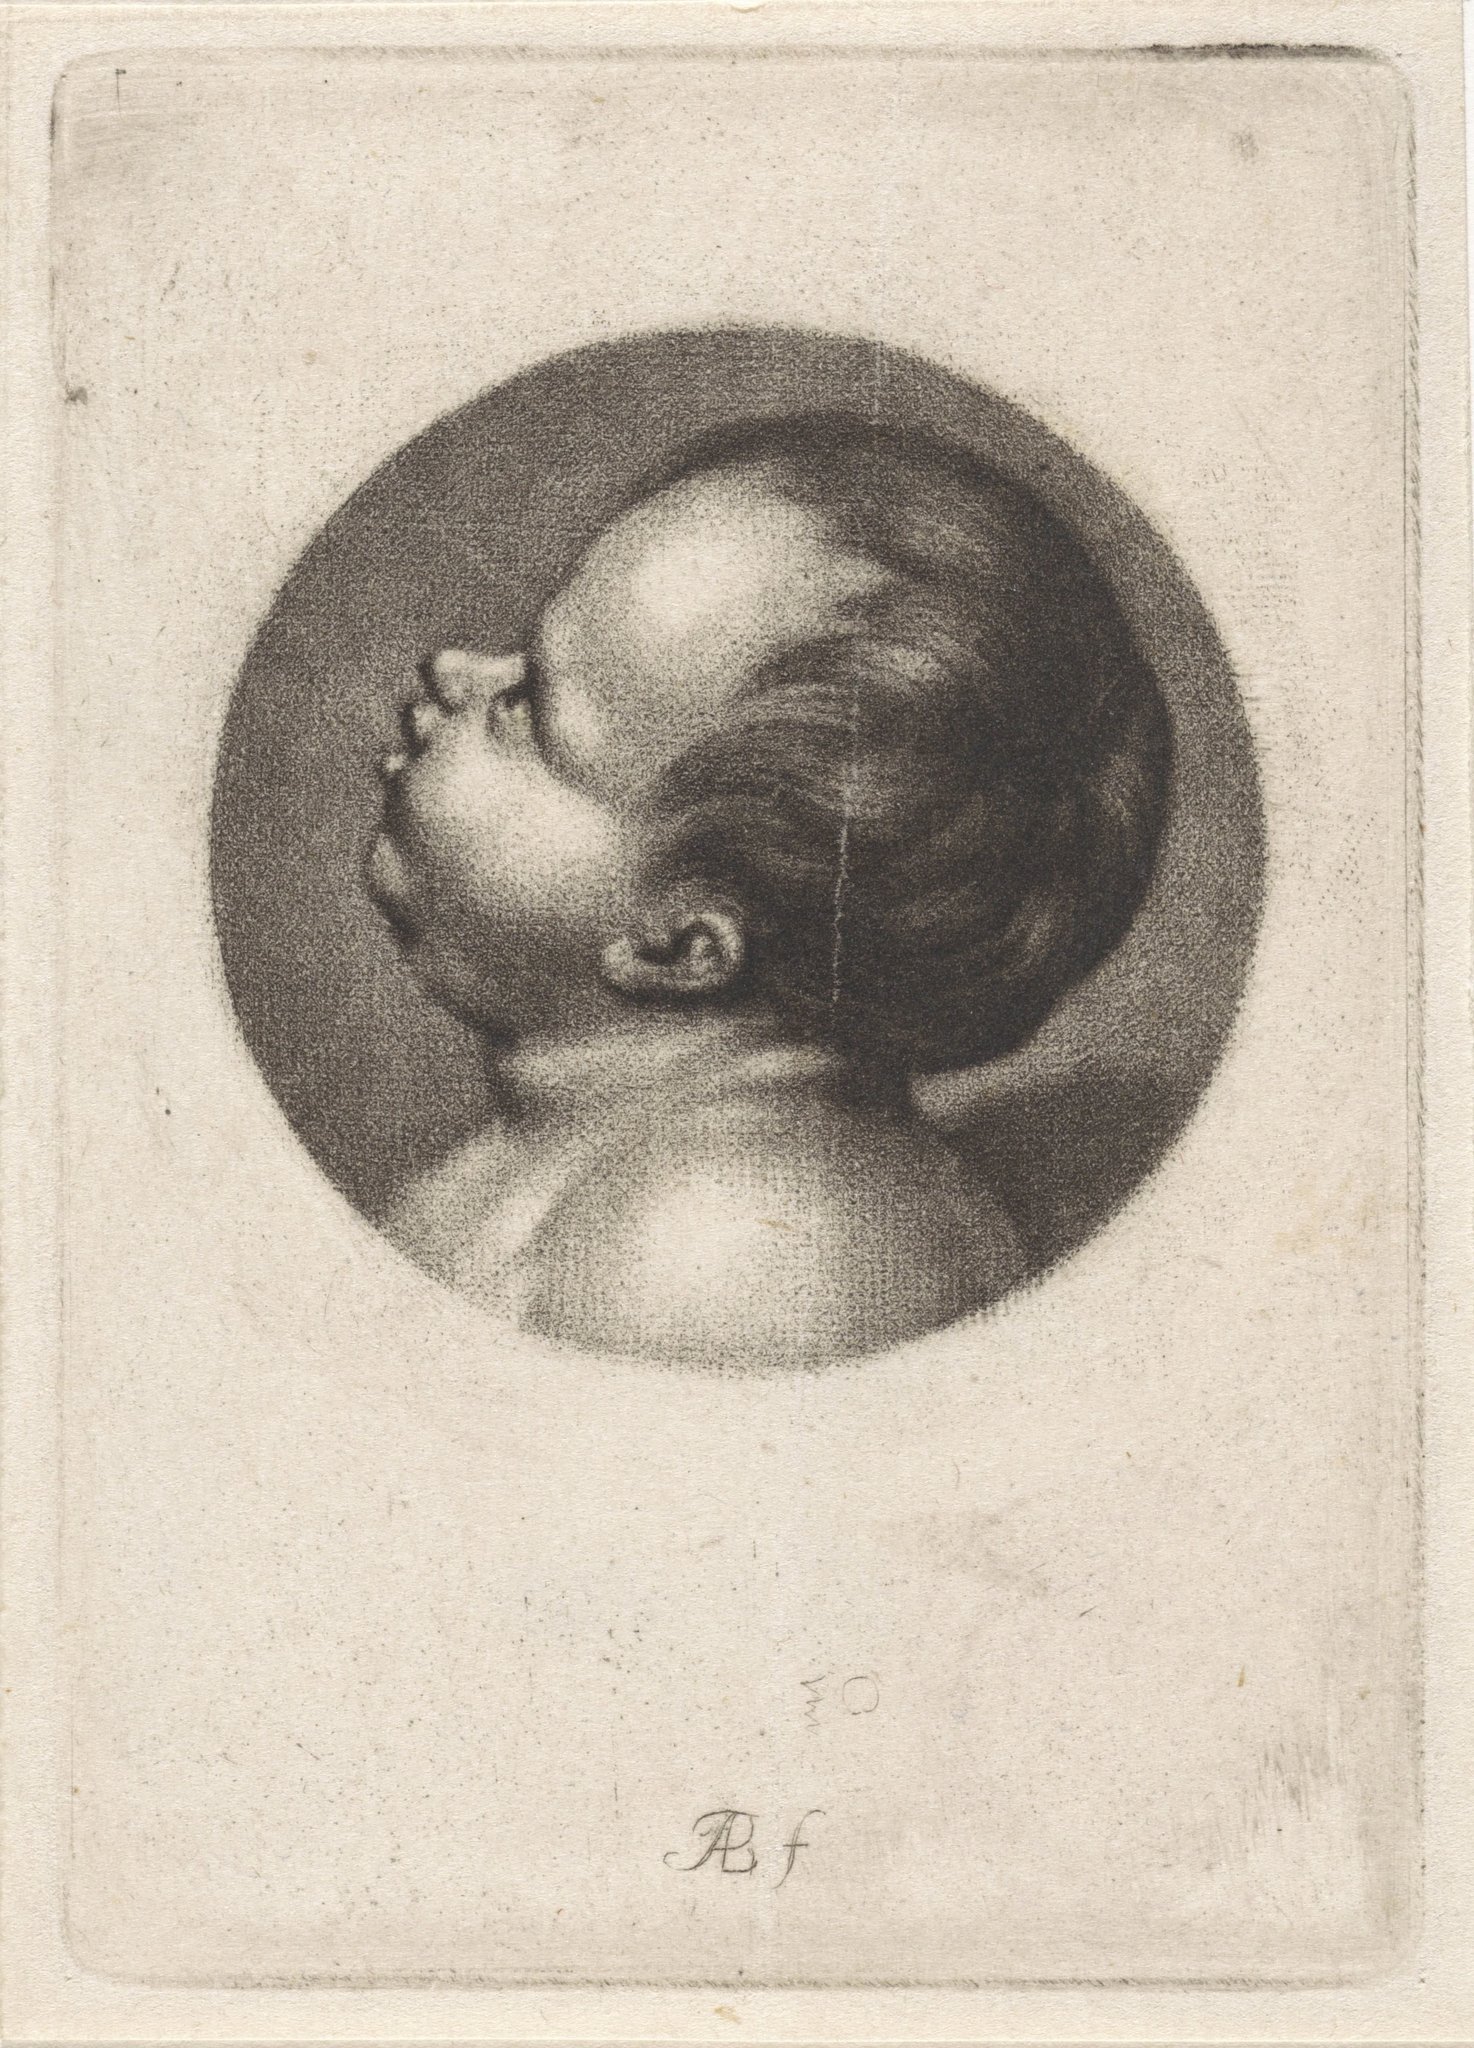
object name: print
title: Buste van een jong kind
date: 1652-1690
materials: paper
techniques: etching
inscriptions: collector's mark: Lugt 240